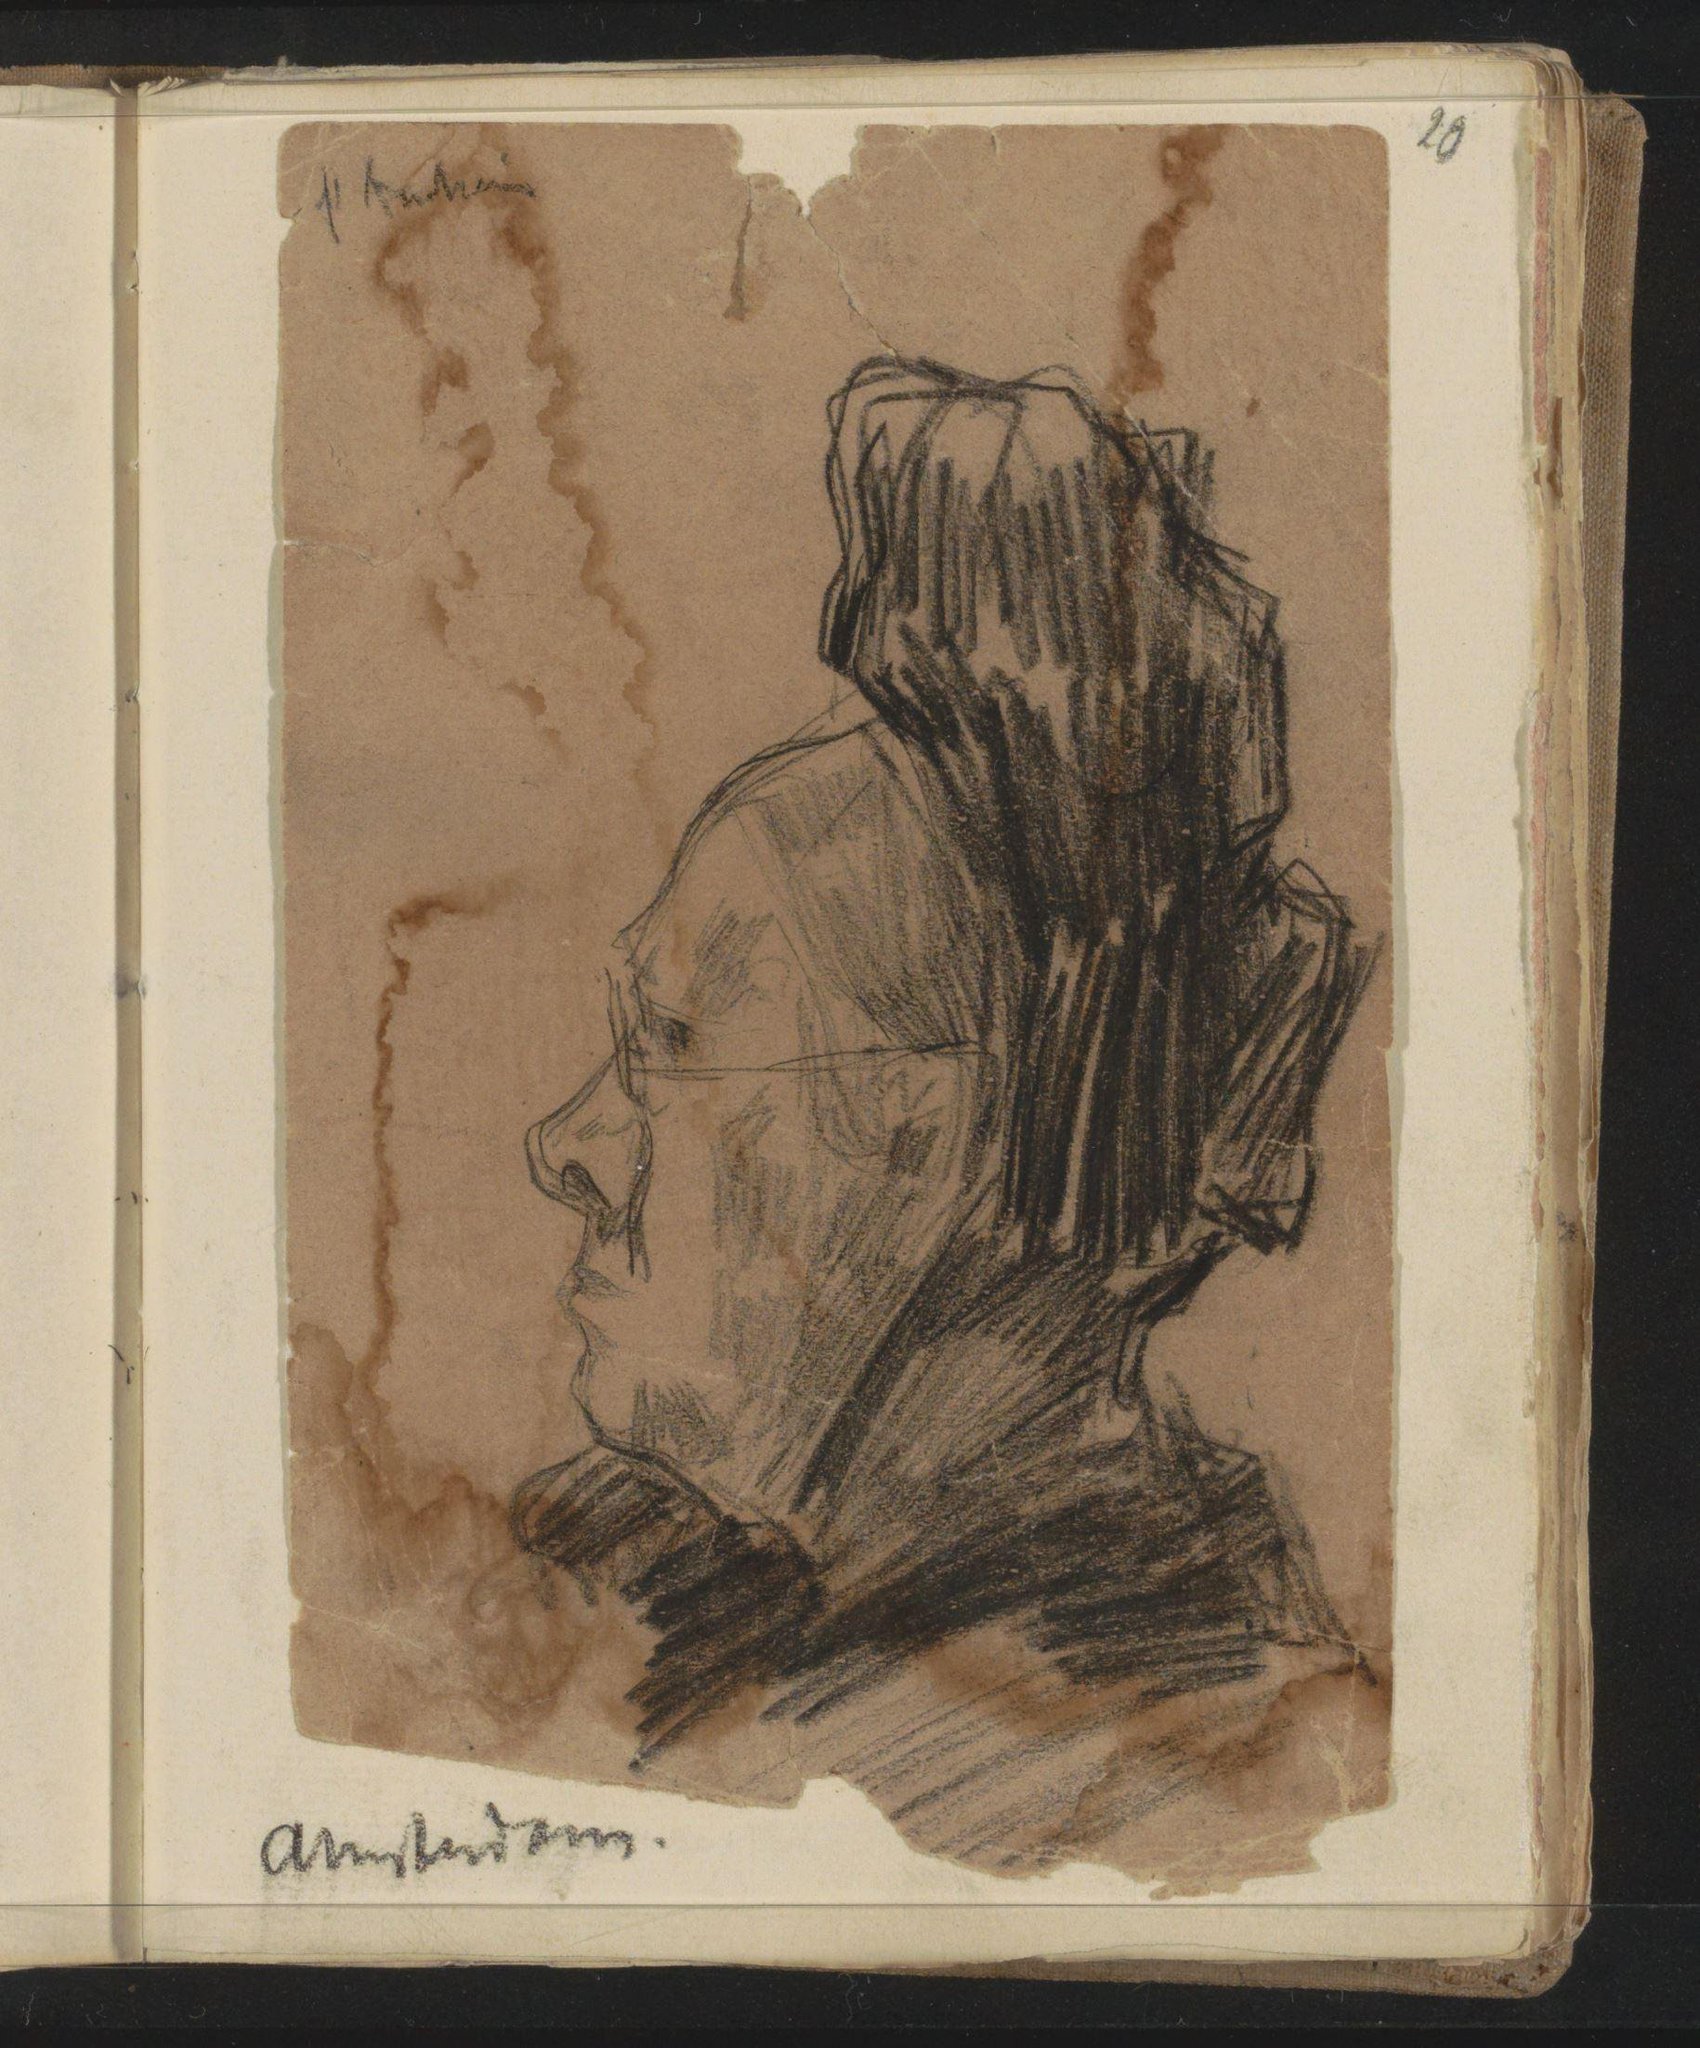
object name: sketchbook leaf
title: Oude vrouw, in profiel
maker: floris arntzenius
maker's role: draughtsman, print maker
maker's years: 1864-1925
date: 1883-1914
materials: chalk, paper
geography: amsterdam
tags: old woman (+ sideview, profile)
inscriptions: signature: ‘Fl Arntzenius’, annotation: ‘Amsterdam.’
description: Blad, geplakt op pagina 20 uit een schetsboek met 82 pagina's.